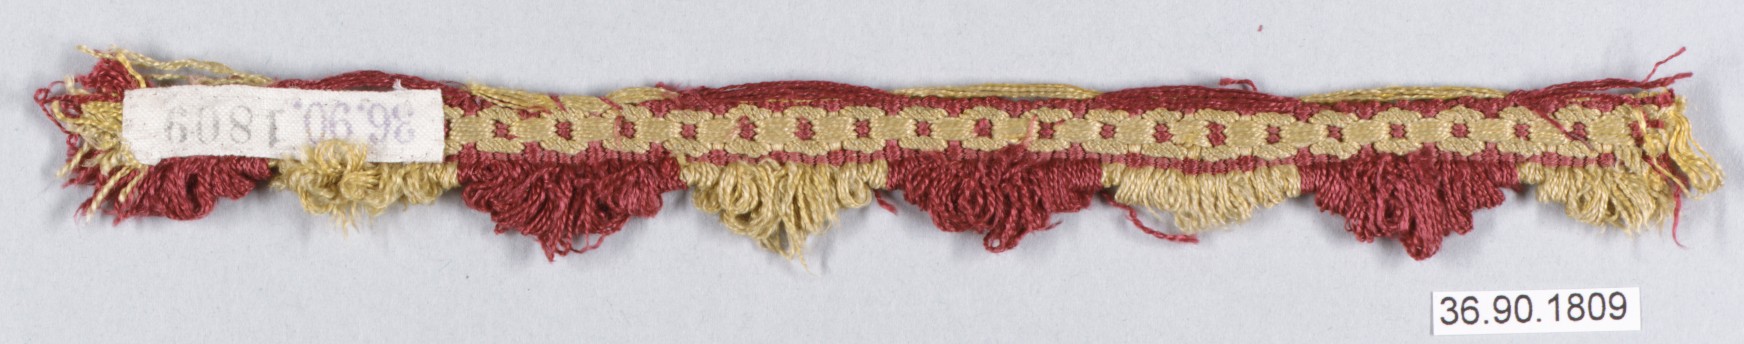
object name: fringe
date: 1767-1800